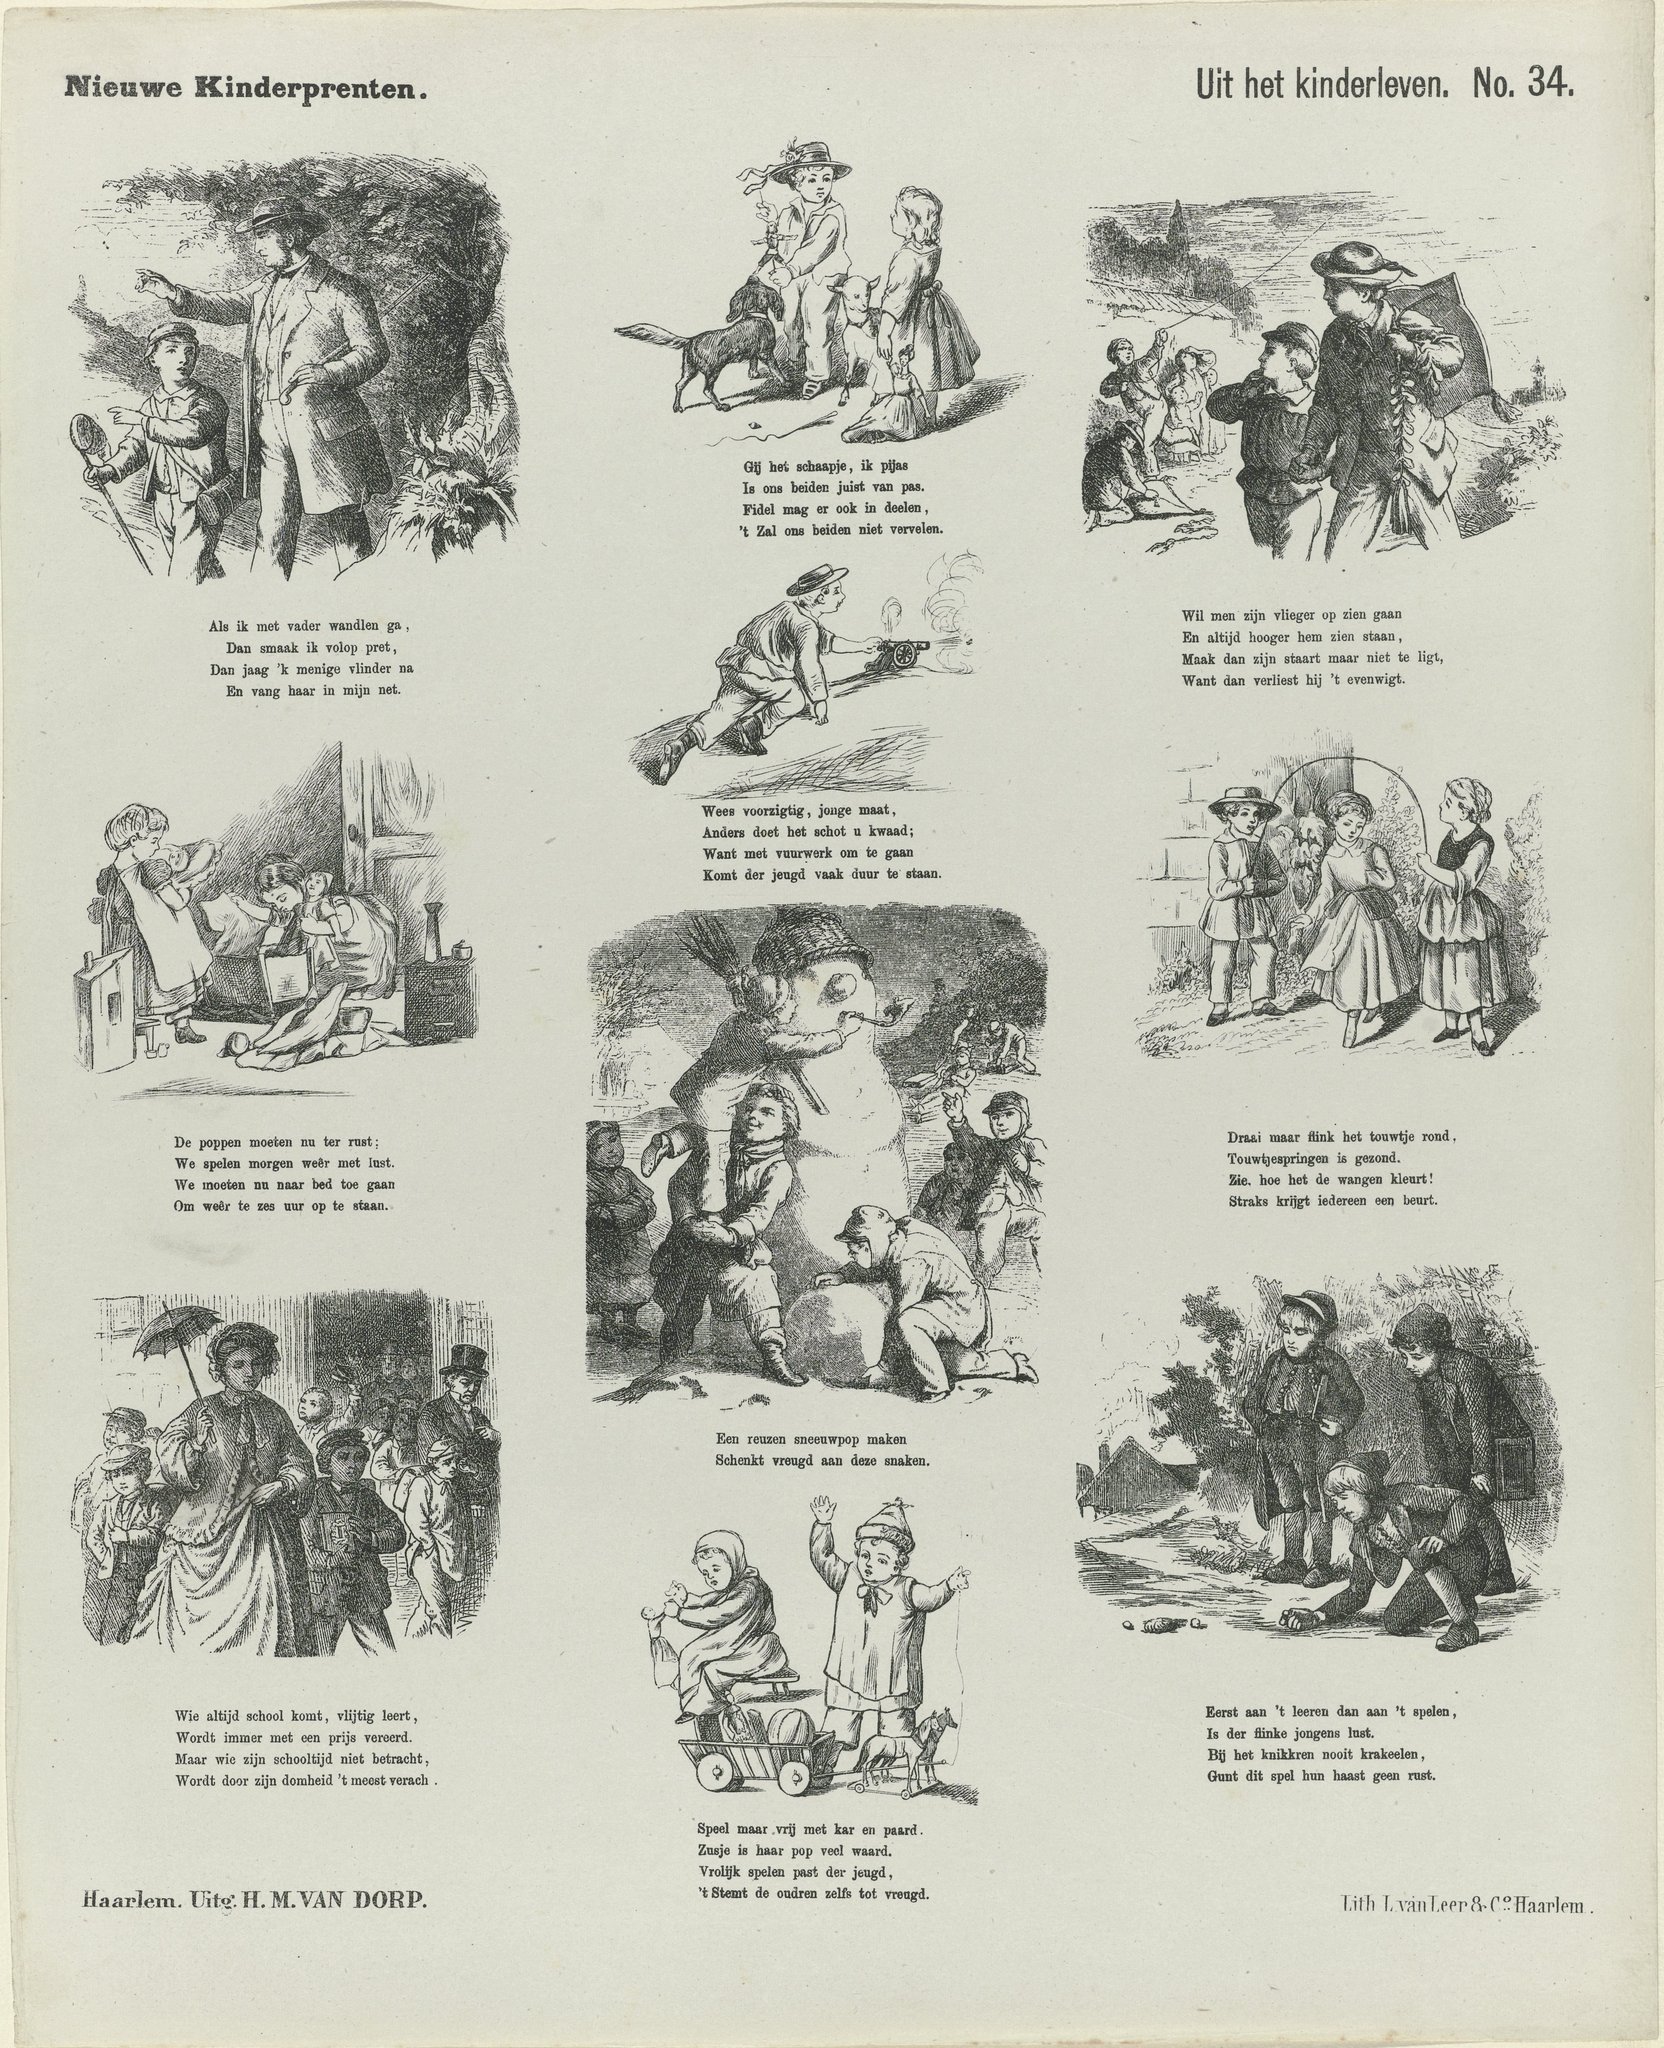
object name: popular print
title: Nieuwe kinderprenten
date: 1872-1883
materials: paper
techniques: letterpress printing, lithograph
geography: haarlem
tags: children's games and plays, (playing with) dolls, games using special objects (marbles, top, hoop, etc.)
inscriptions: collector's mark: Lugt 2760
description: Blad met 10 voorstellingen van kinderspelen en bezigheden, waaronder vlinders vangen, spelen met de pop, vliegeren en knikkeren. Onder elke afbeelding een onderschrift. Genummerd rechtsboven: No. 34.